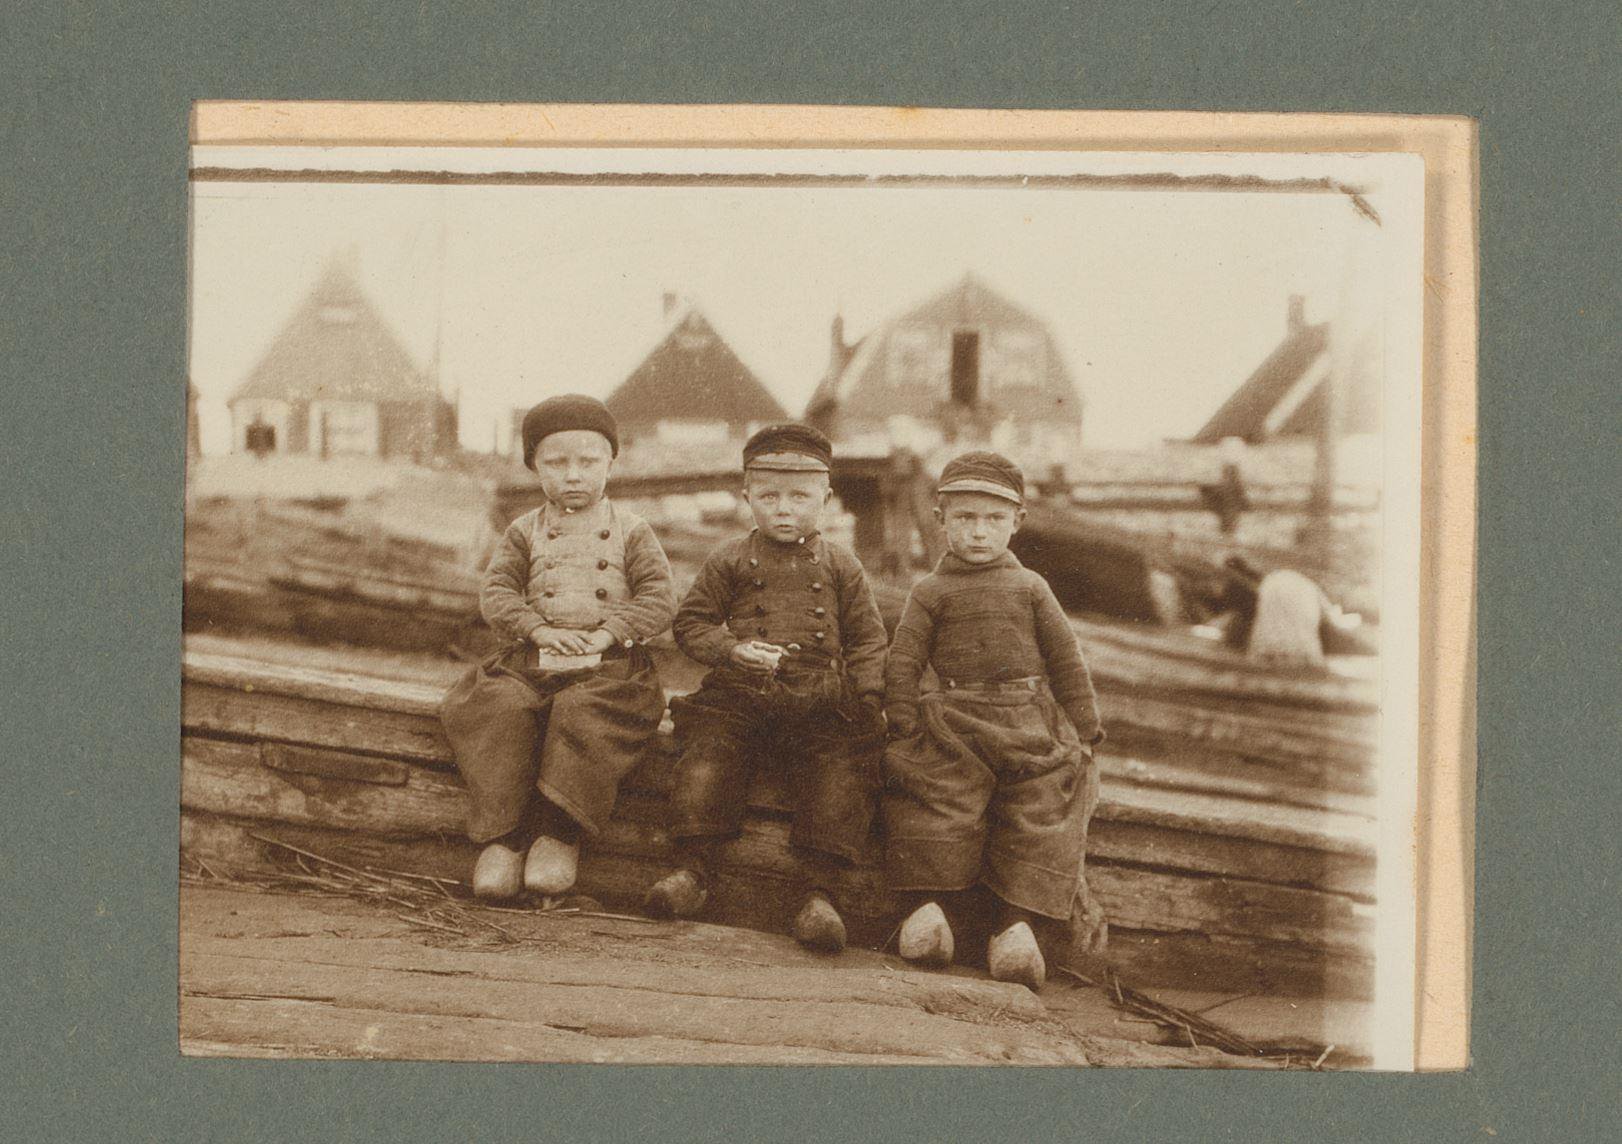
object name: photograph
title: Drie jongens in klederdracht, zittend op een paar bielzen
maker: george hidderley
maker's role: fotograaf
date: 1920-1940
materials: photographic support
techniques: gelatin silver print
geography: netherlands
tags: boy (child between toddler and youth) (+ three persons), historical persons, folk costume, regional costume